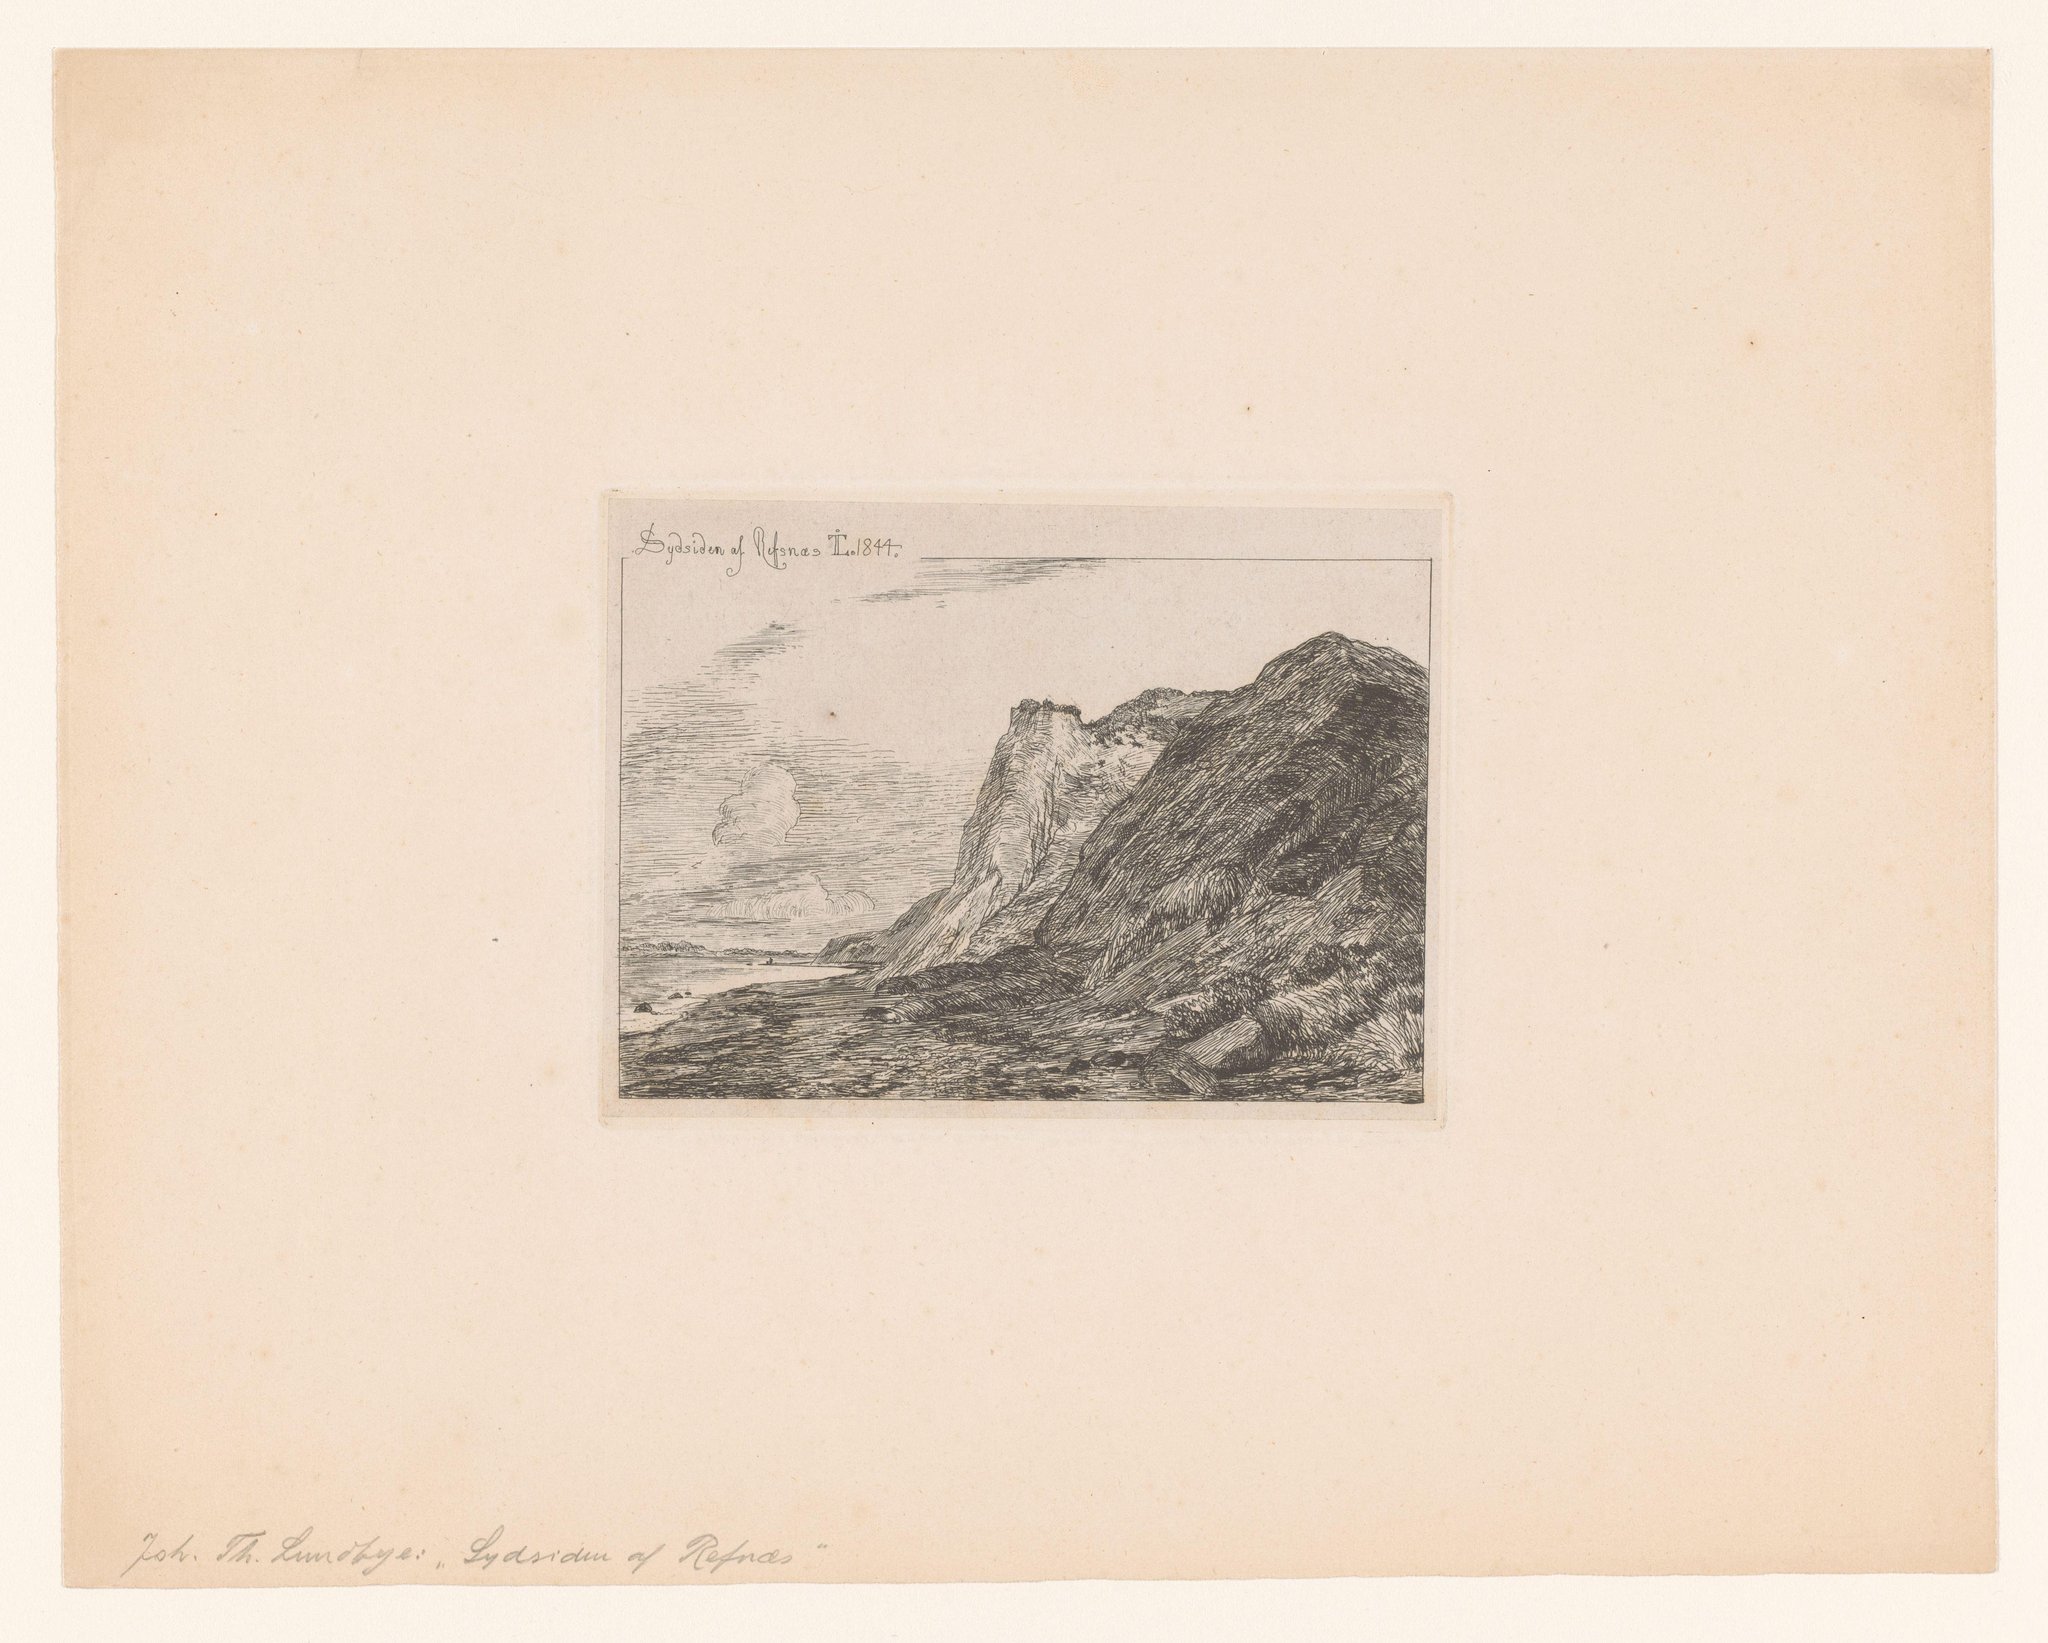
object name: print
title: Sydsiden af Refsnaes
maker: johan thomas lundbye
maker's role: print maker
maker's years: 1818-1848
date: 1844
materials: paper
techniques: etching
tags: coastal cliff or crag, norway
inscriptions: collector's mark: Lugt 2760, collector's mark: Lugt 2228